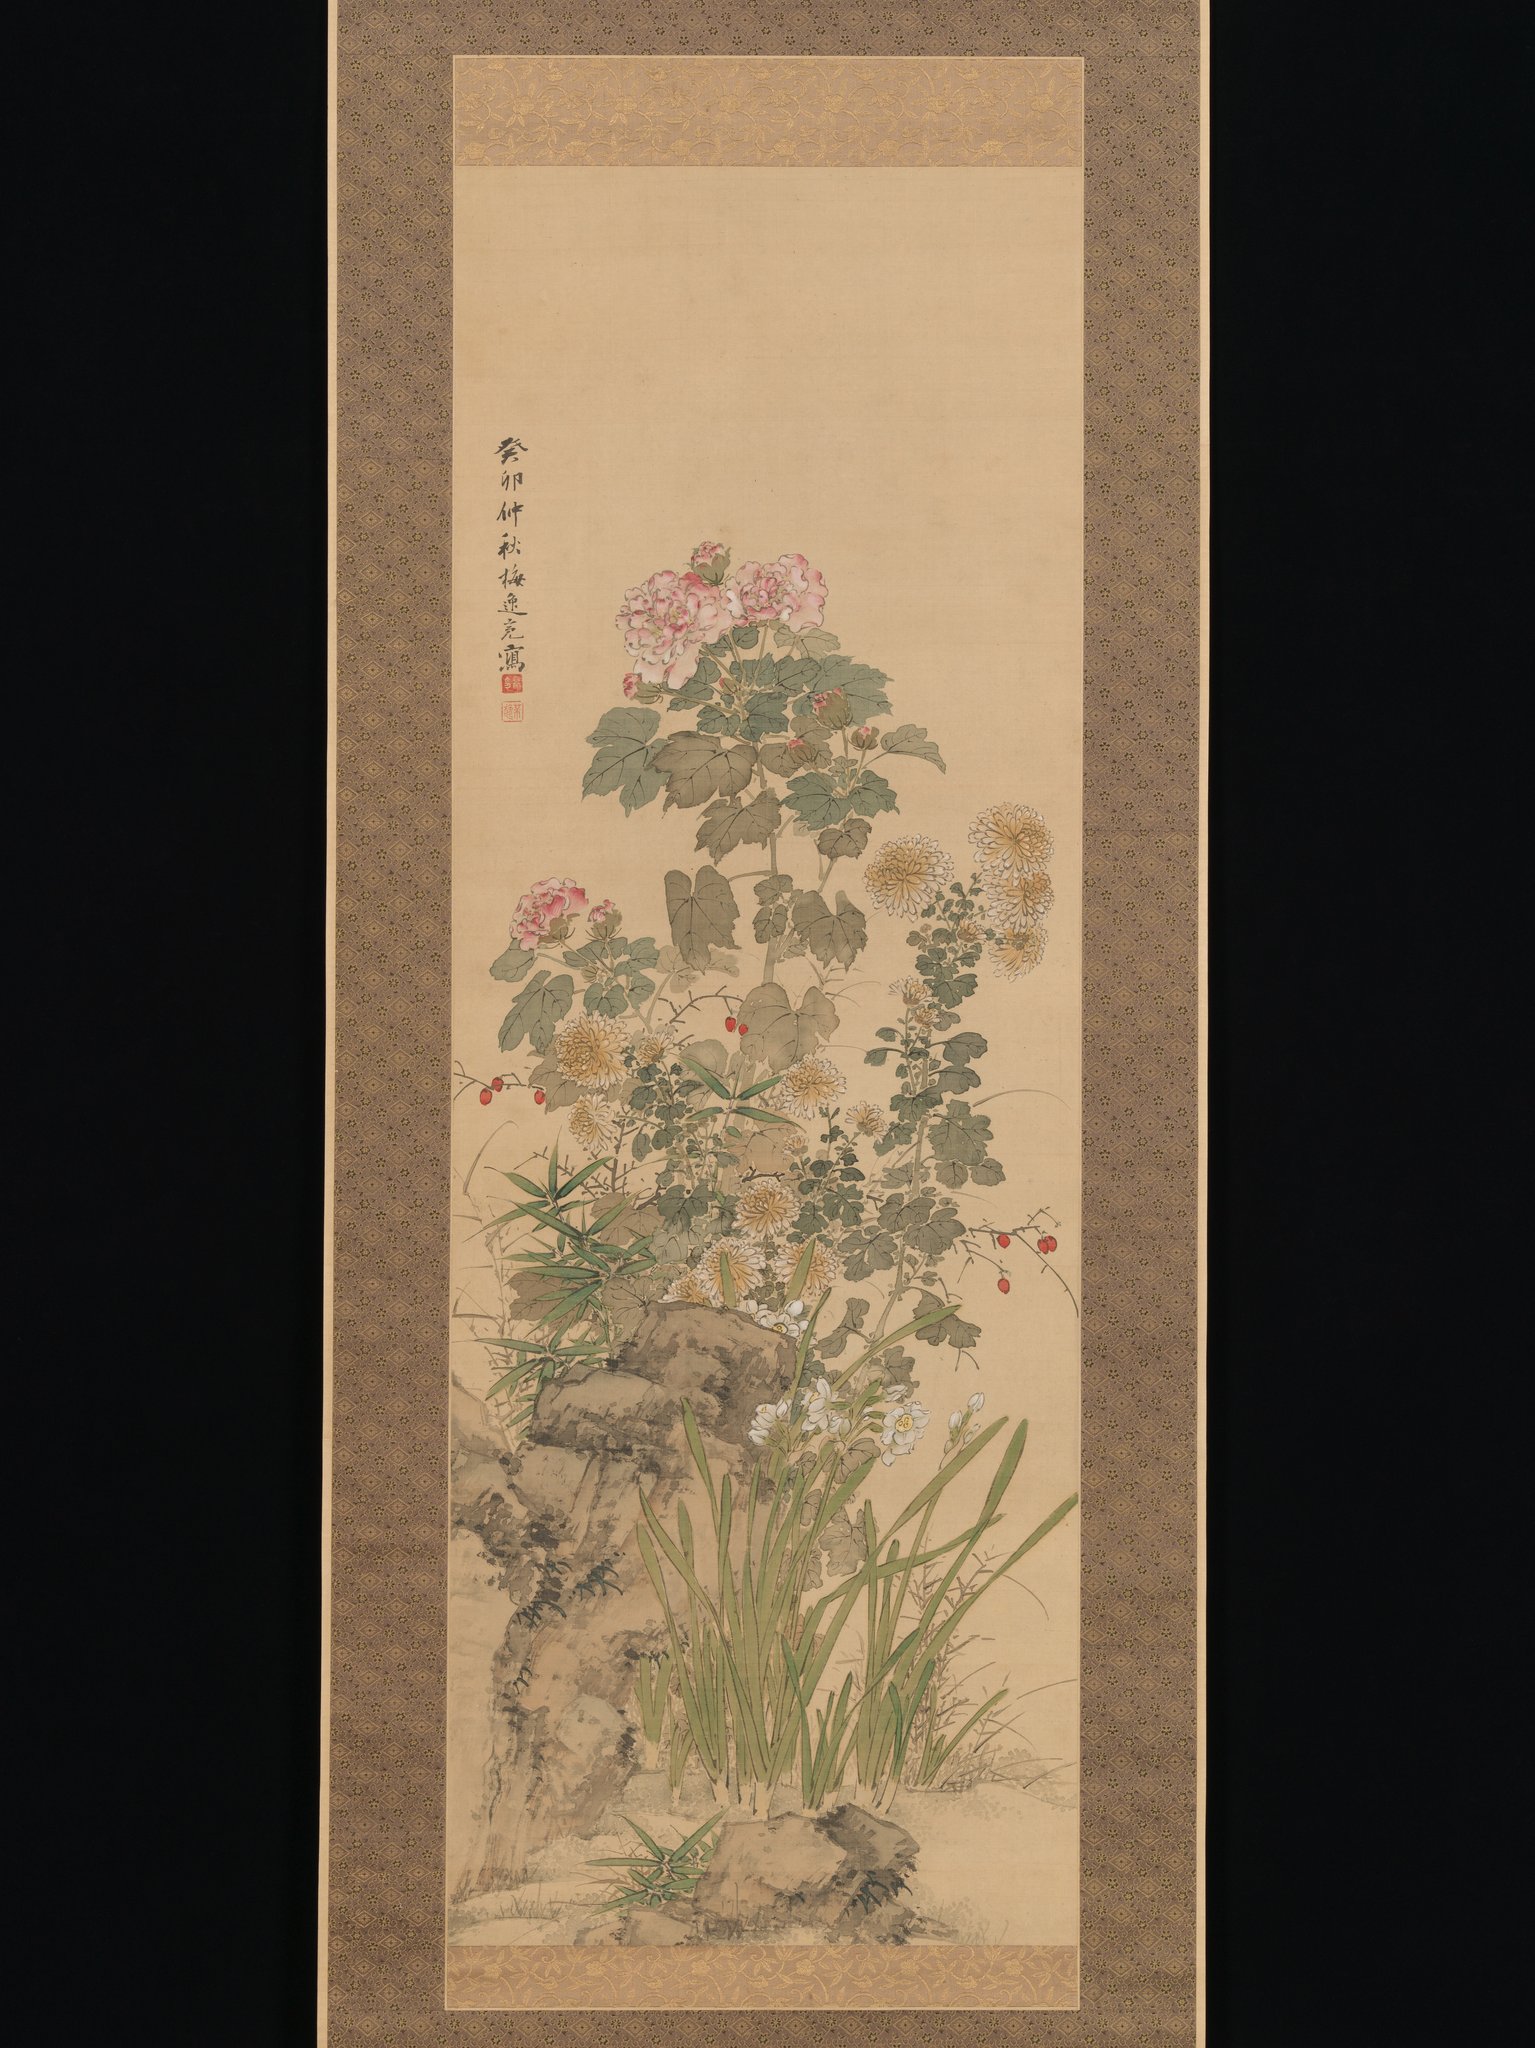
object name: hanging scroll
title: Flowers and Grasses of Autumn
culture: japanese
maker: yamamoto baiitsu 山本梅逸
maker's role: artist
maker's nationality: japanese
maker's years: 1783-1856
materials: ink, silk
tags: flowers